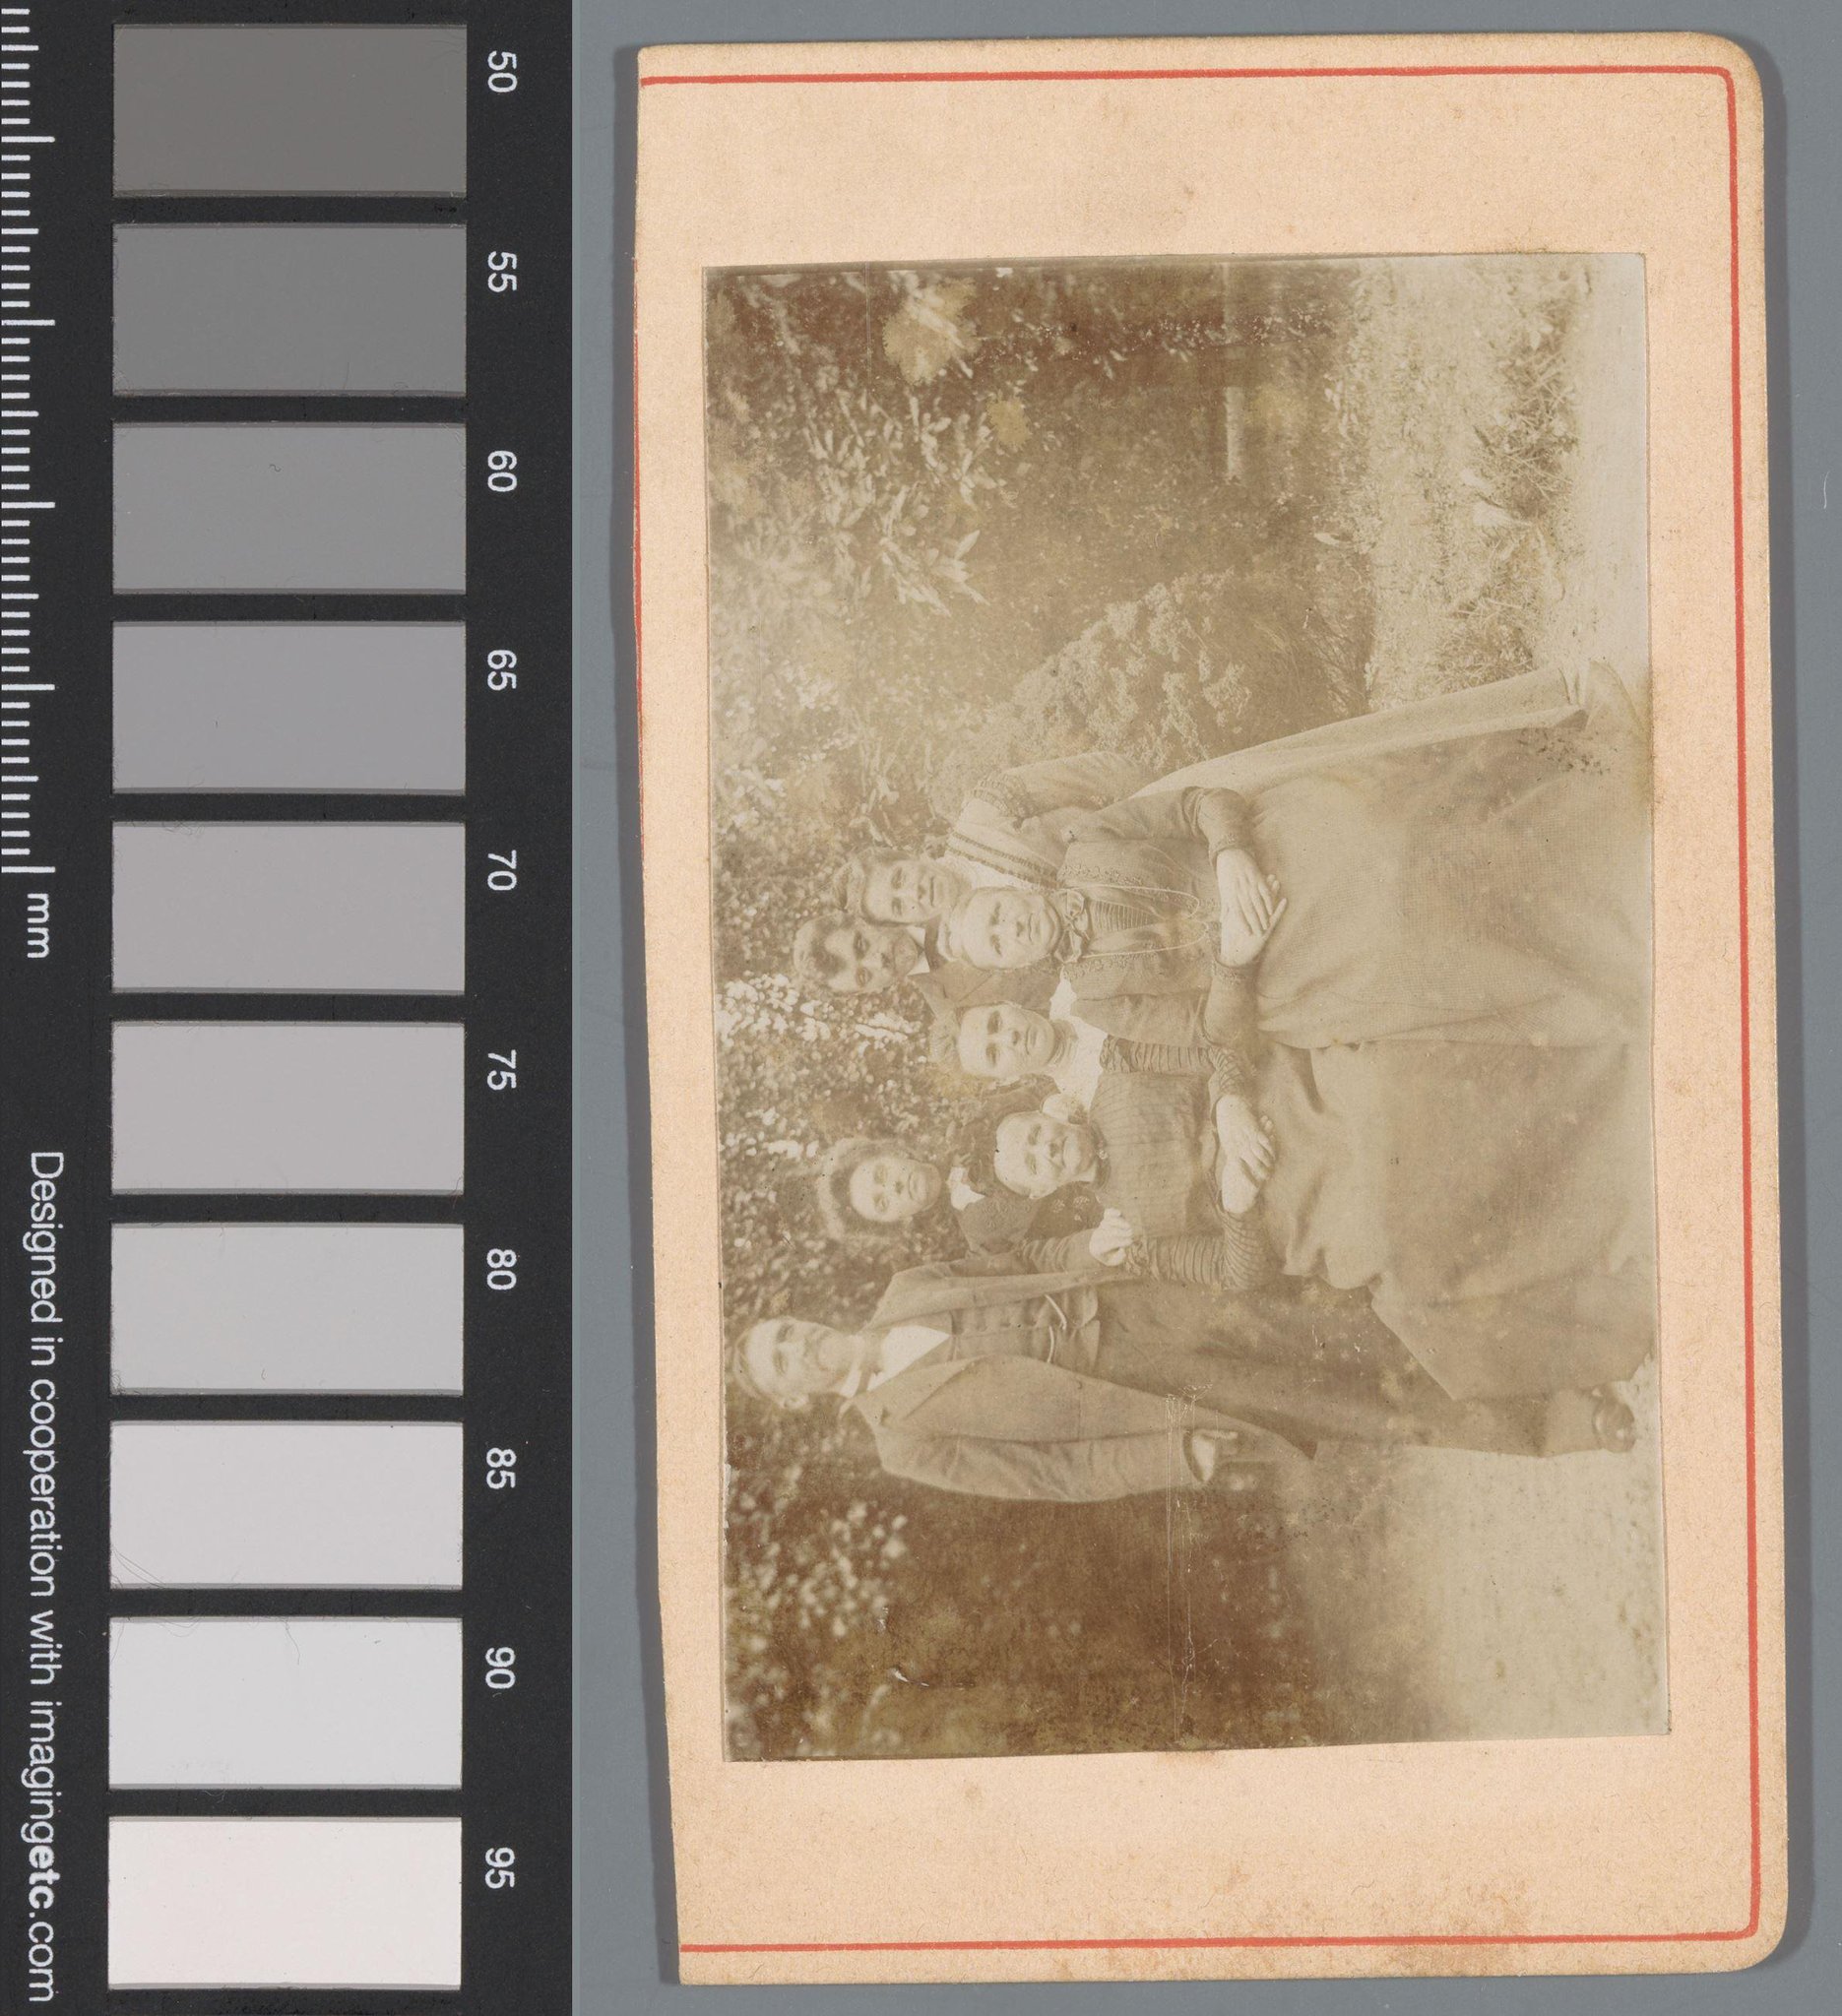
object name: photograph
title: Groepsportret van vijf onbekende vrouwen en twee mannen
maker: Anonymous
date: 1854-1885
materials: cardboard, paper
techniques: albumen print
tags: adult woman, adult man, anonymous historical persons portrayed in a group, in a group-portrait